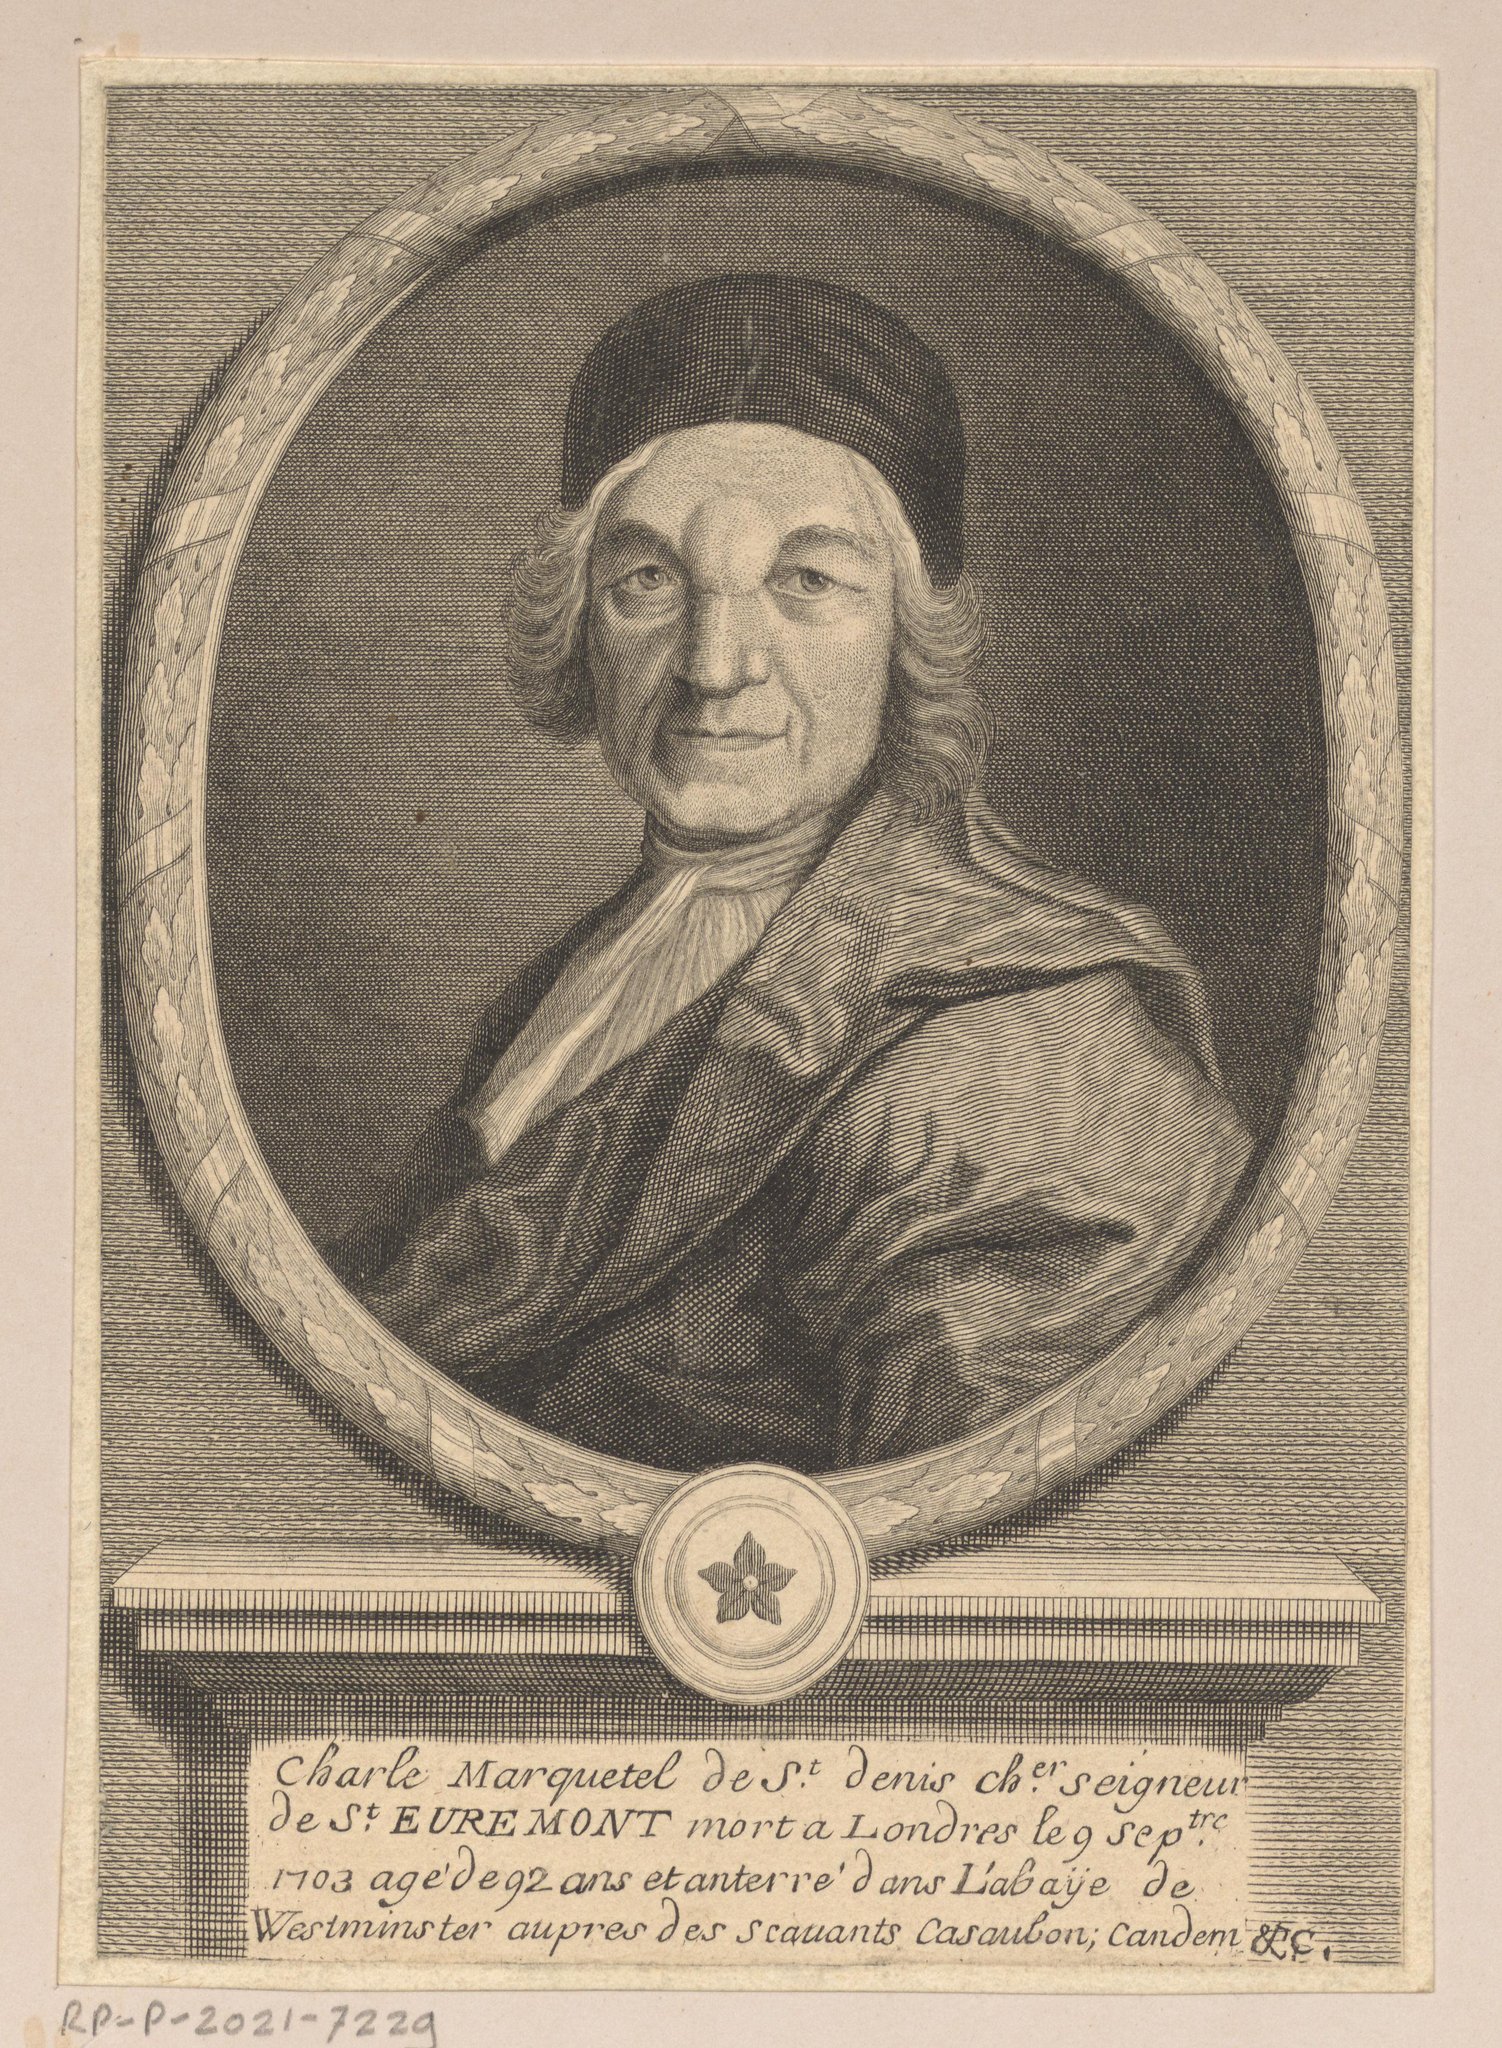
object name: print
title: Portret van Charles de Saint-Évremond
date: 1691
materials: paper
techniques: engraving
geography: paris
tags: military service, historical persons, portrait of a writer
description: Latere staat van prent gebruikt in: Adamoli, Pierre. Livre des portraits des roys de France depuis Pharamon et de plusieurs (...). Parijs: s.n., 1728.